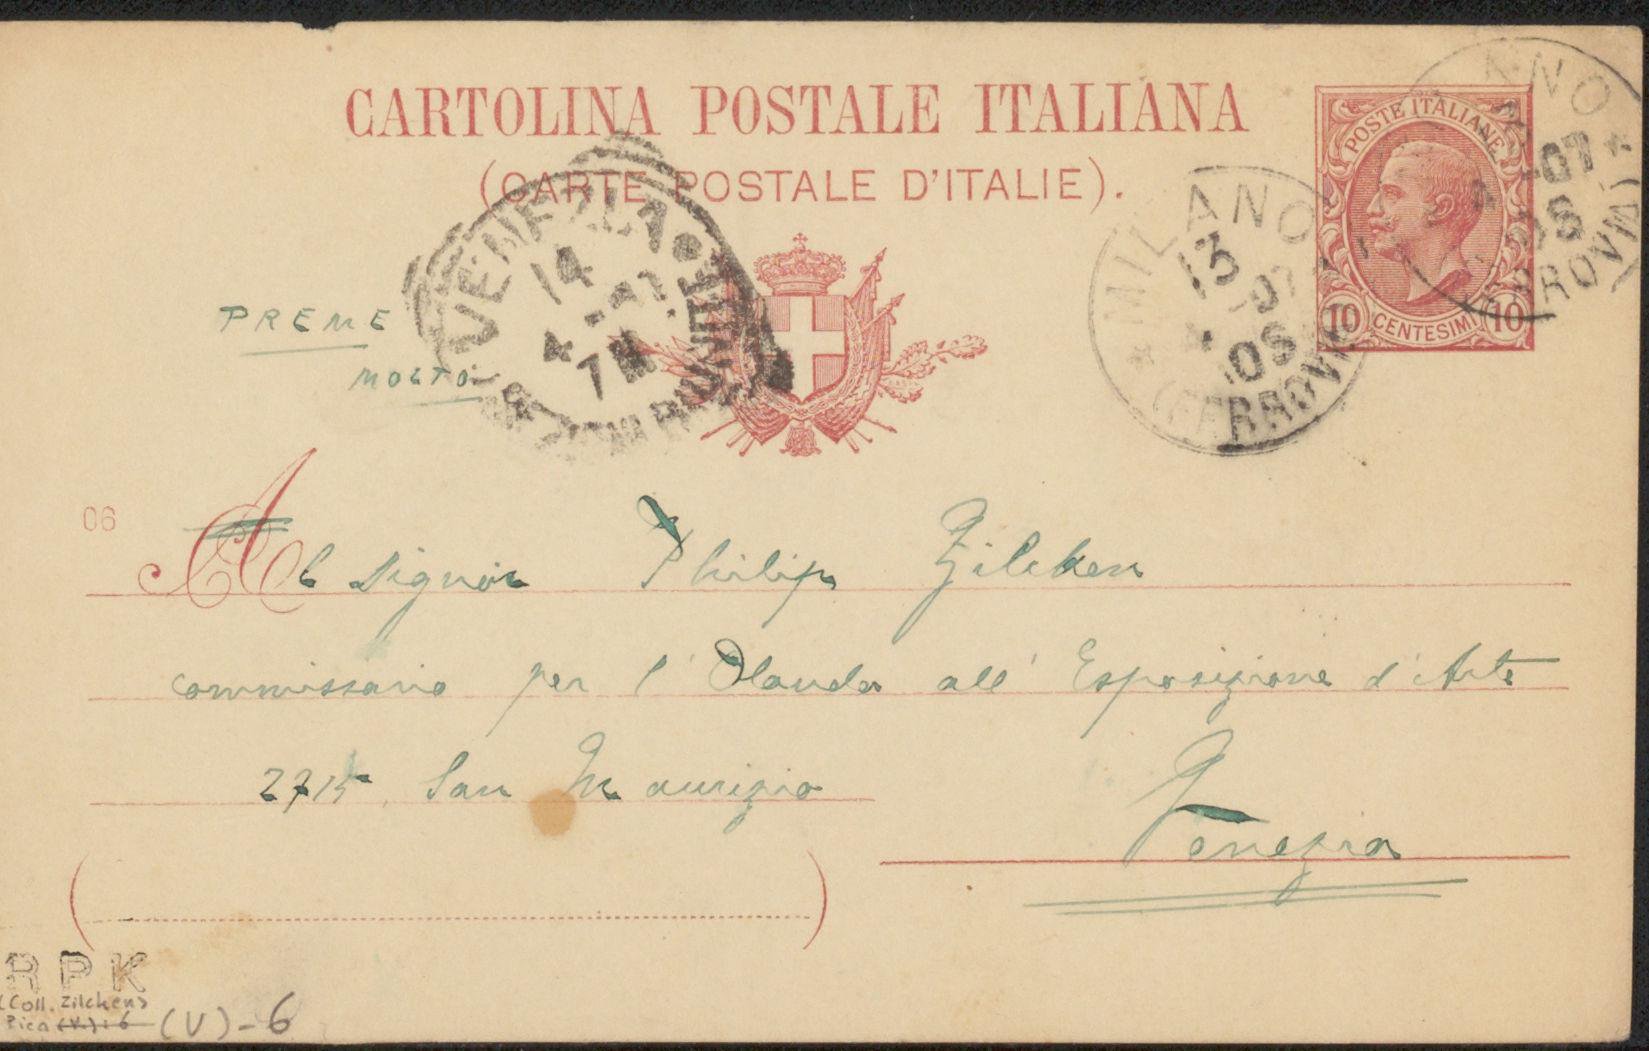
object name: postcard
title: Briefkaart aan Philip Zilcken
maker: vittorio pica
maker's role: criticus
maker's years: 1864-1930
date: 1908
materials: cardboard, ink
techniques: pen, writing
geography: milan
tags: rome, politician, antonio fradeletto, painter, philip zilcken, drawing, photography, cinematography, exhibition ~ art, printed matter, venice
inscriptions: collector's mark: ‘RPK’